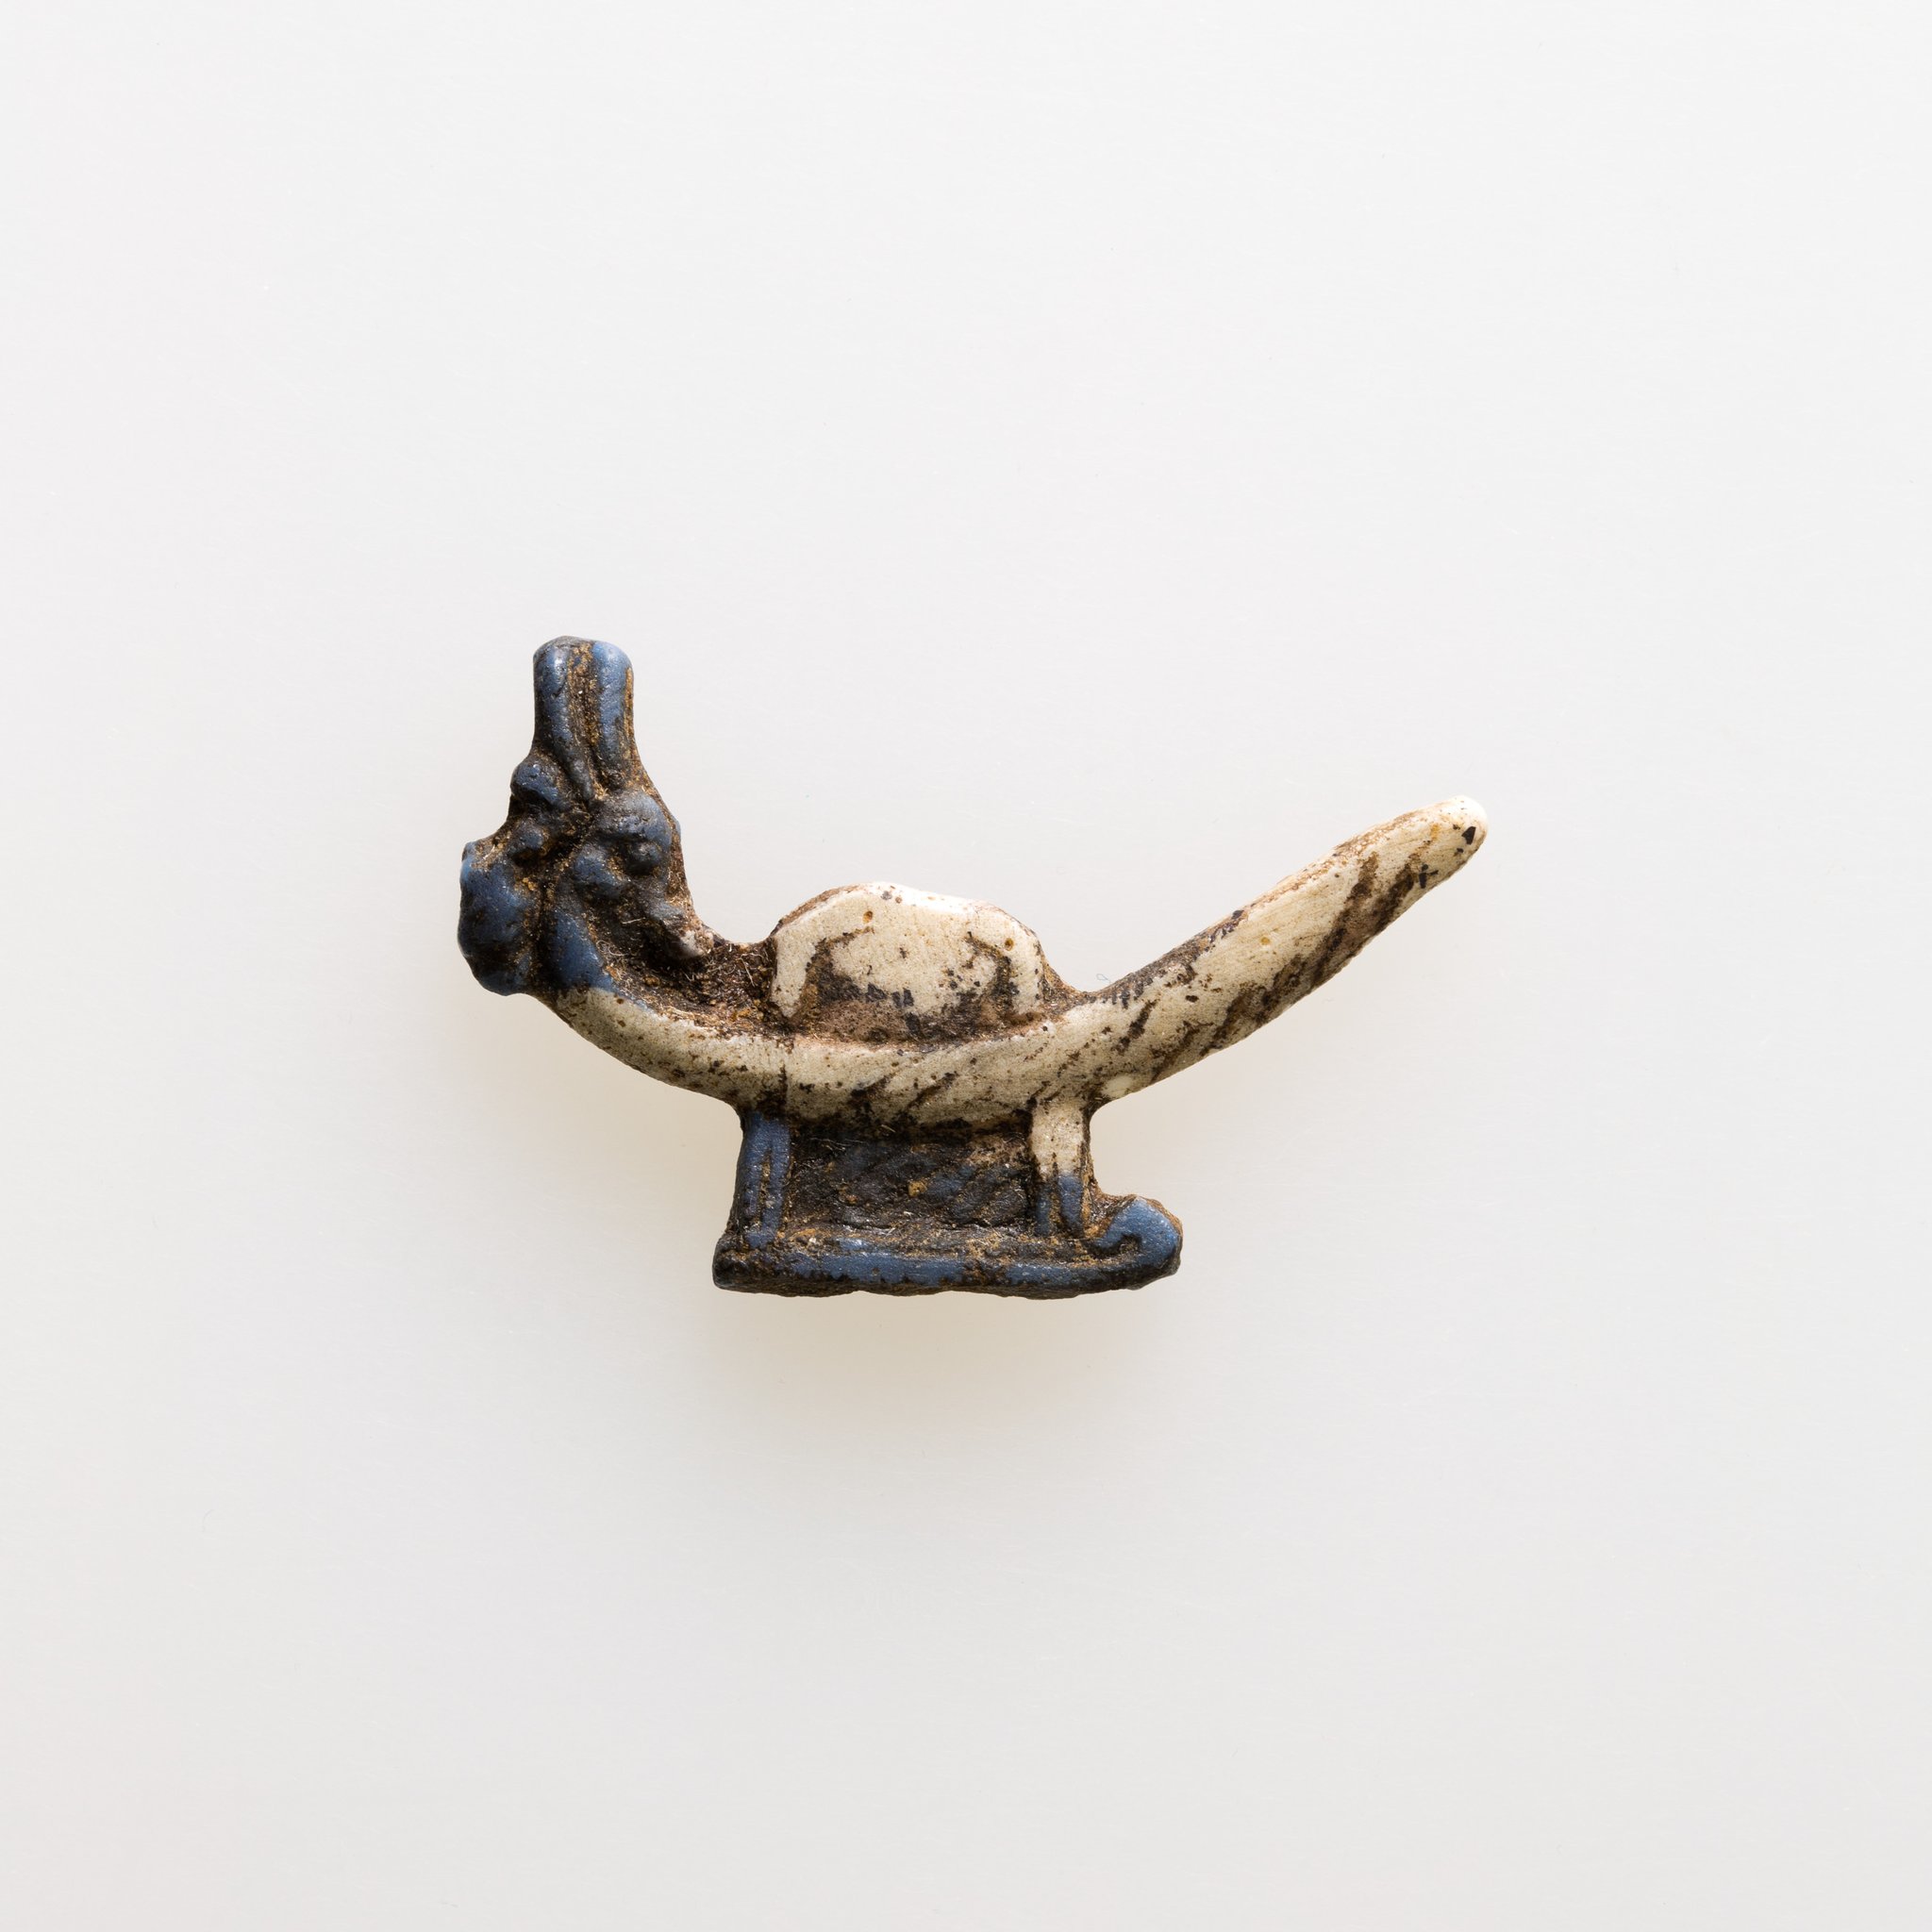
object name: amulet, henu barque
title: Henu barque amulet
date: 400-30 BCE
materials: glass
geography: egypt